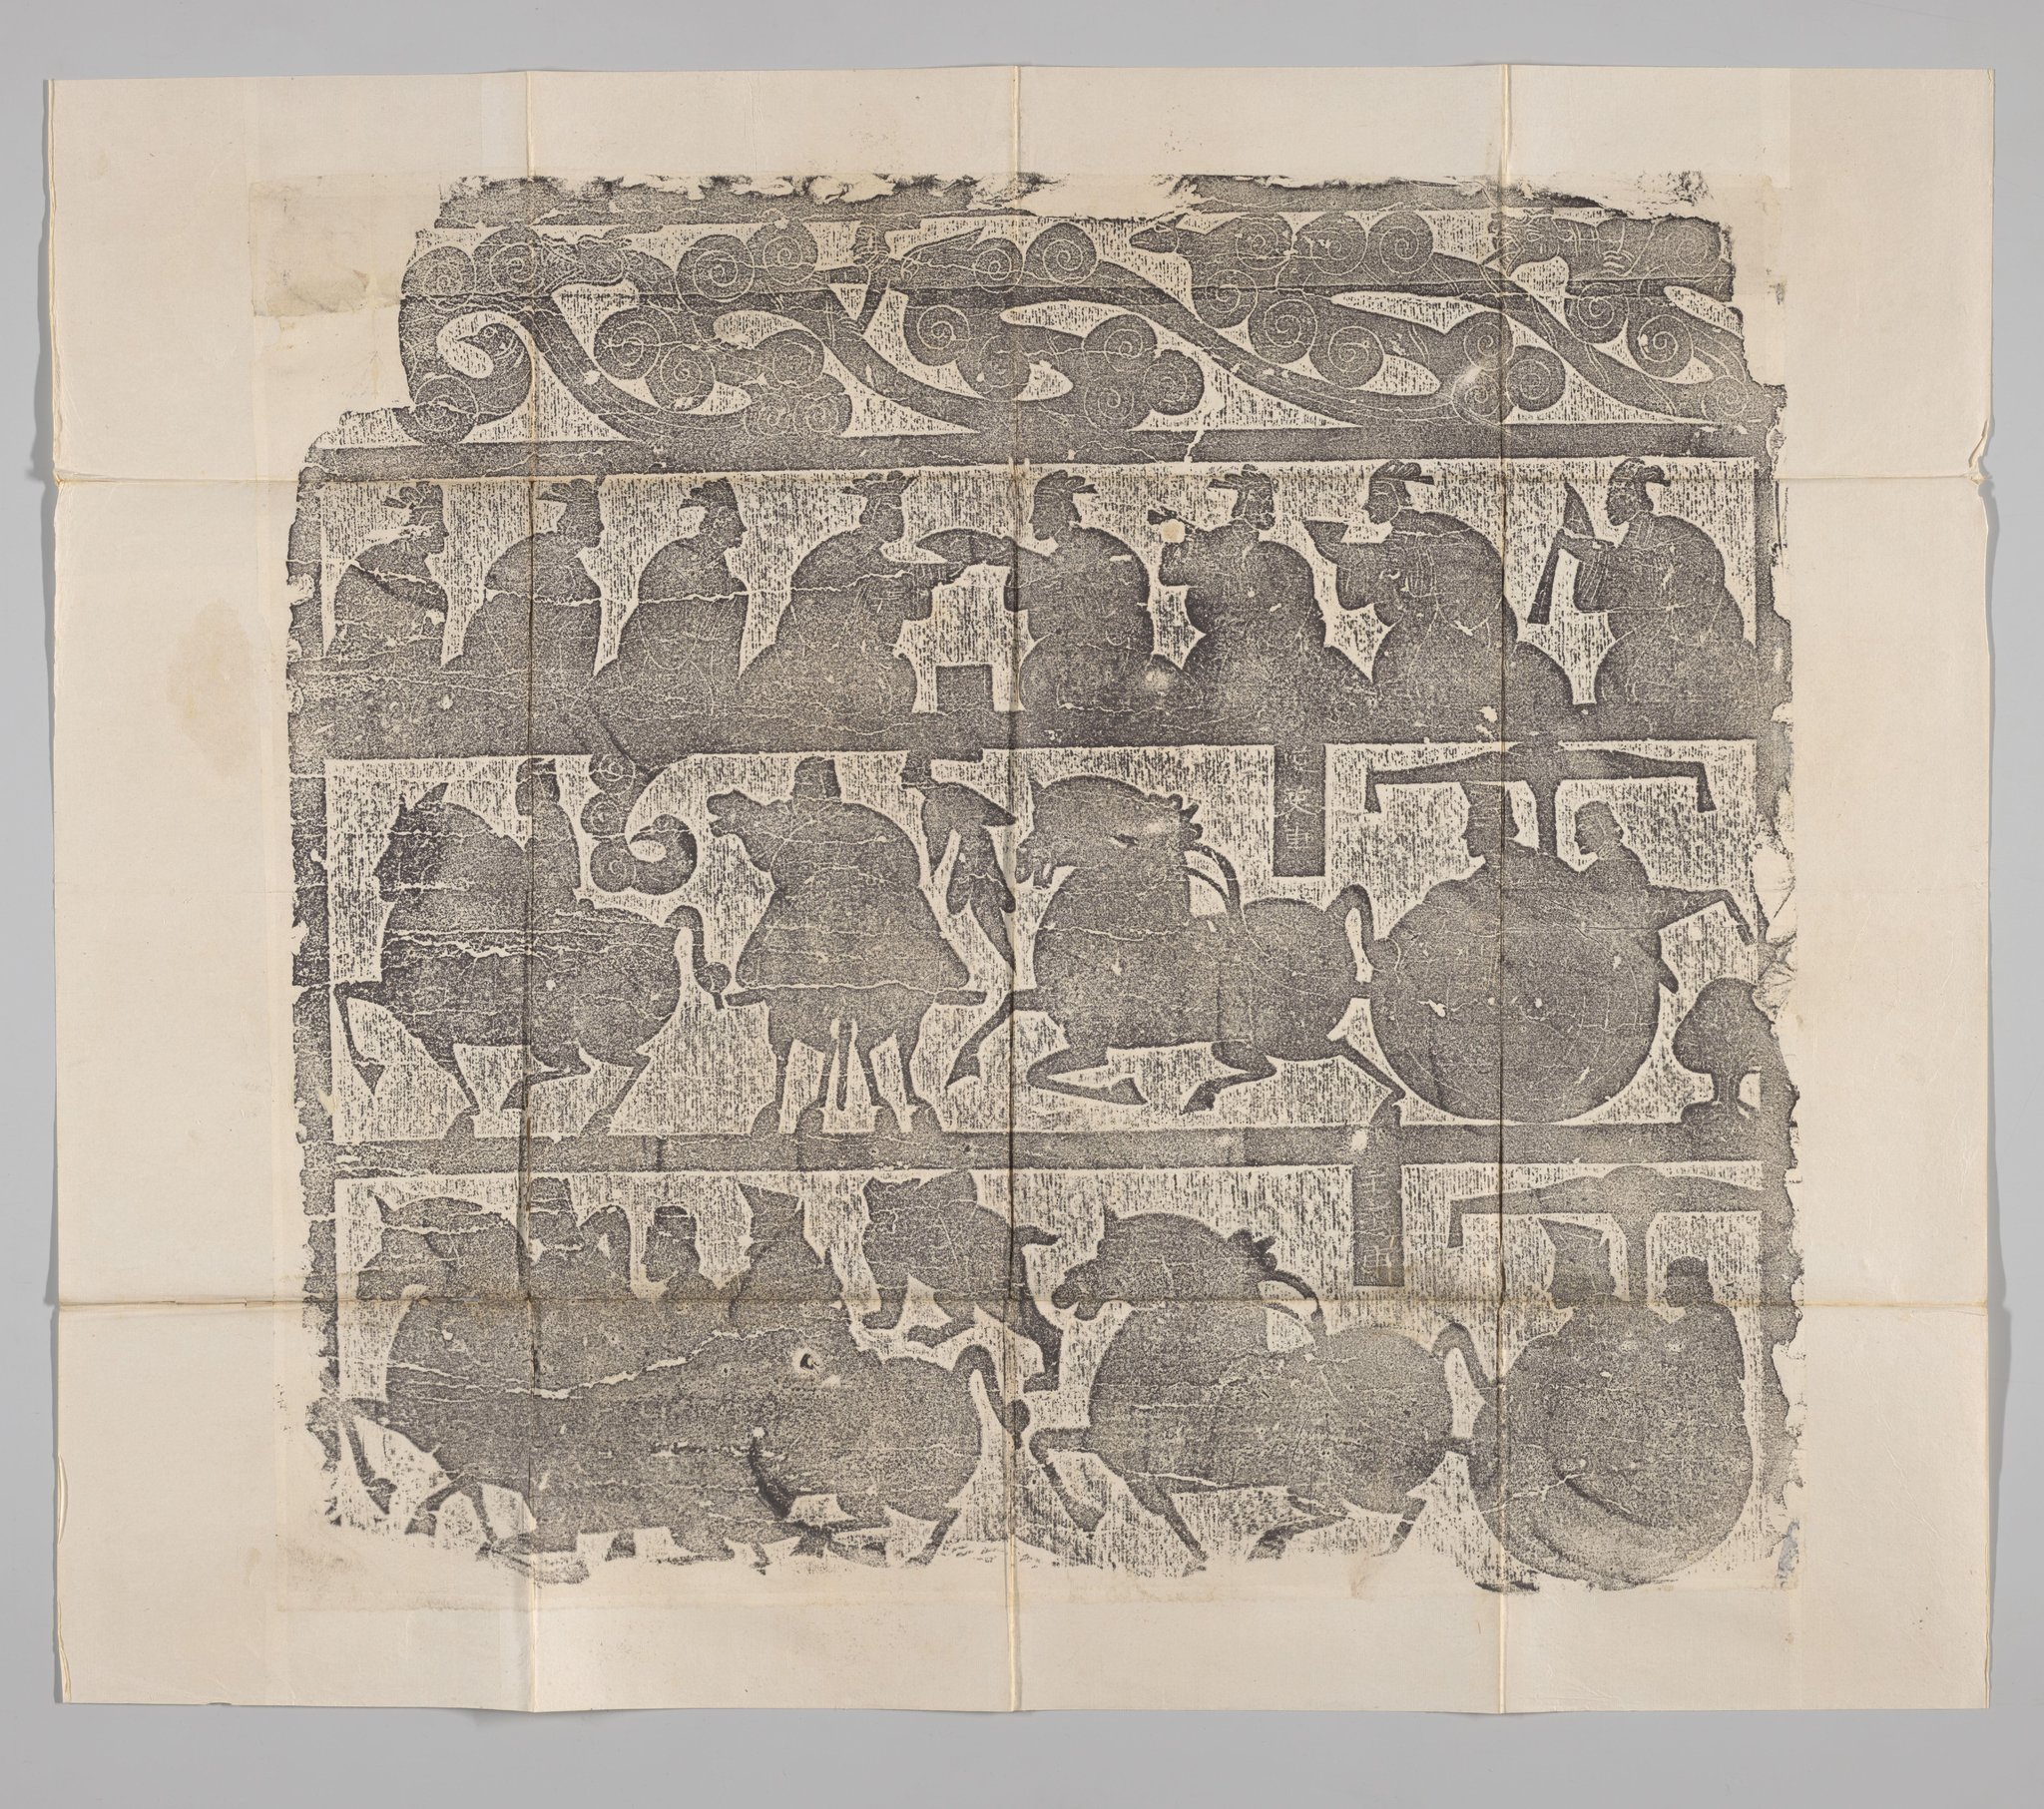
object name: wrijfprent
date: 1900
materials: ink, paper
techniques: rubbing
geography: china